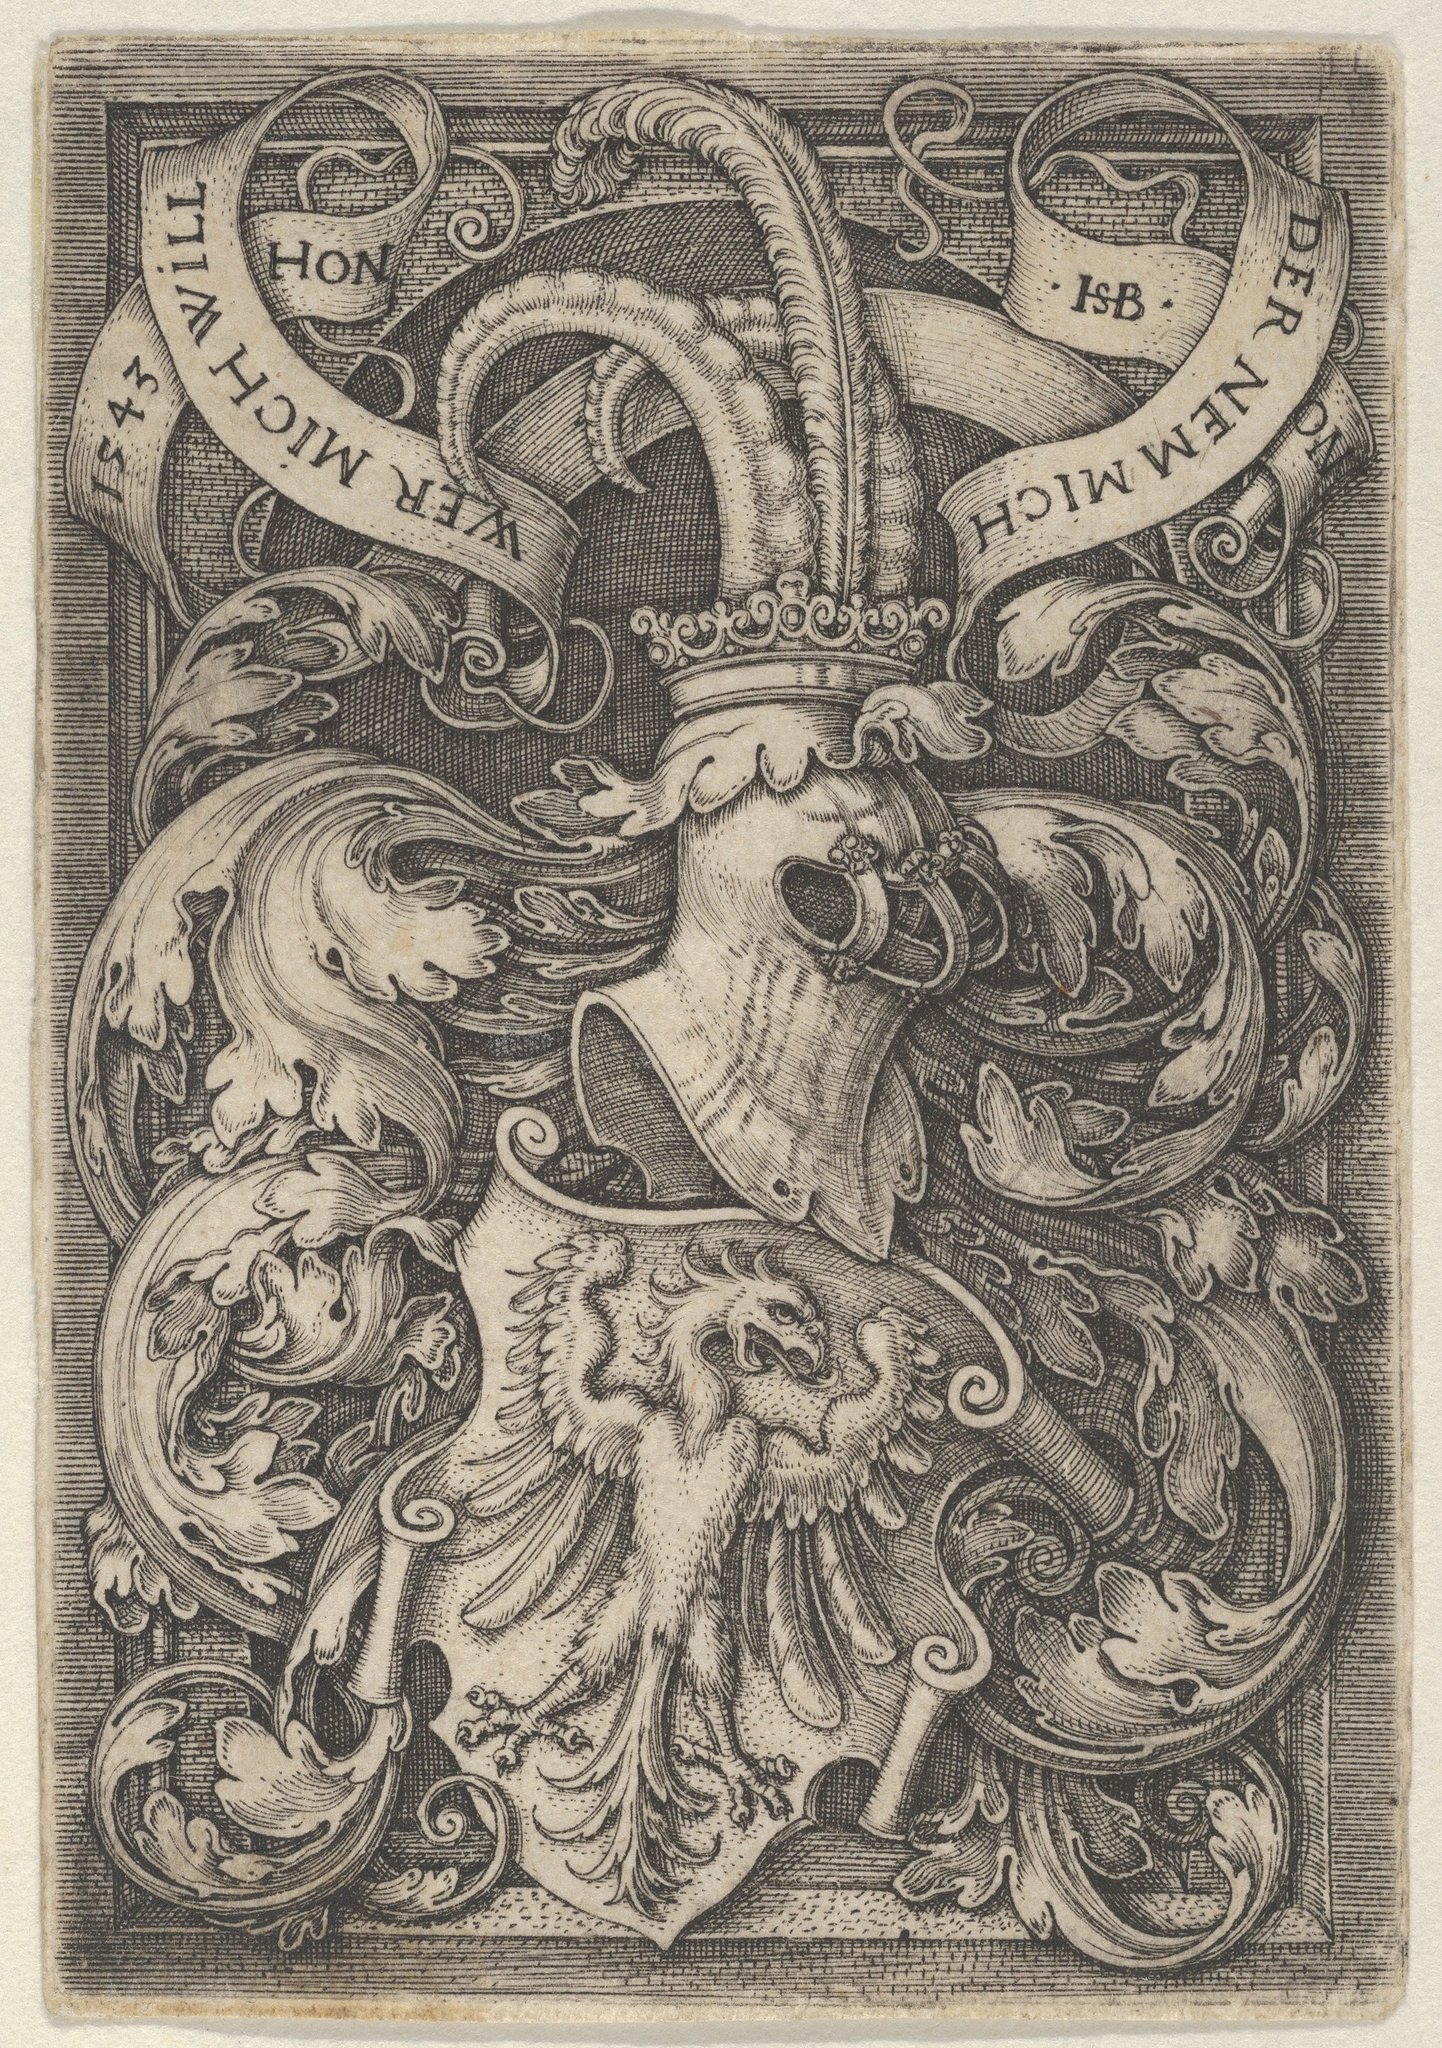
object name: print ornament architecture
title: Coat of Arms with an Eagle Surrounded by Foliage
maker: sebald beham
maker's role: artist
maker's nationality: german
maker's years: 1500-1550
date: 1543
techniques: engraving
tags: eagles,leaves,coat of arms